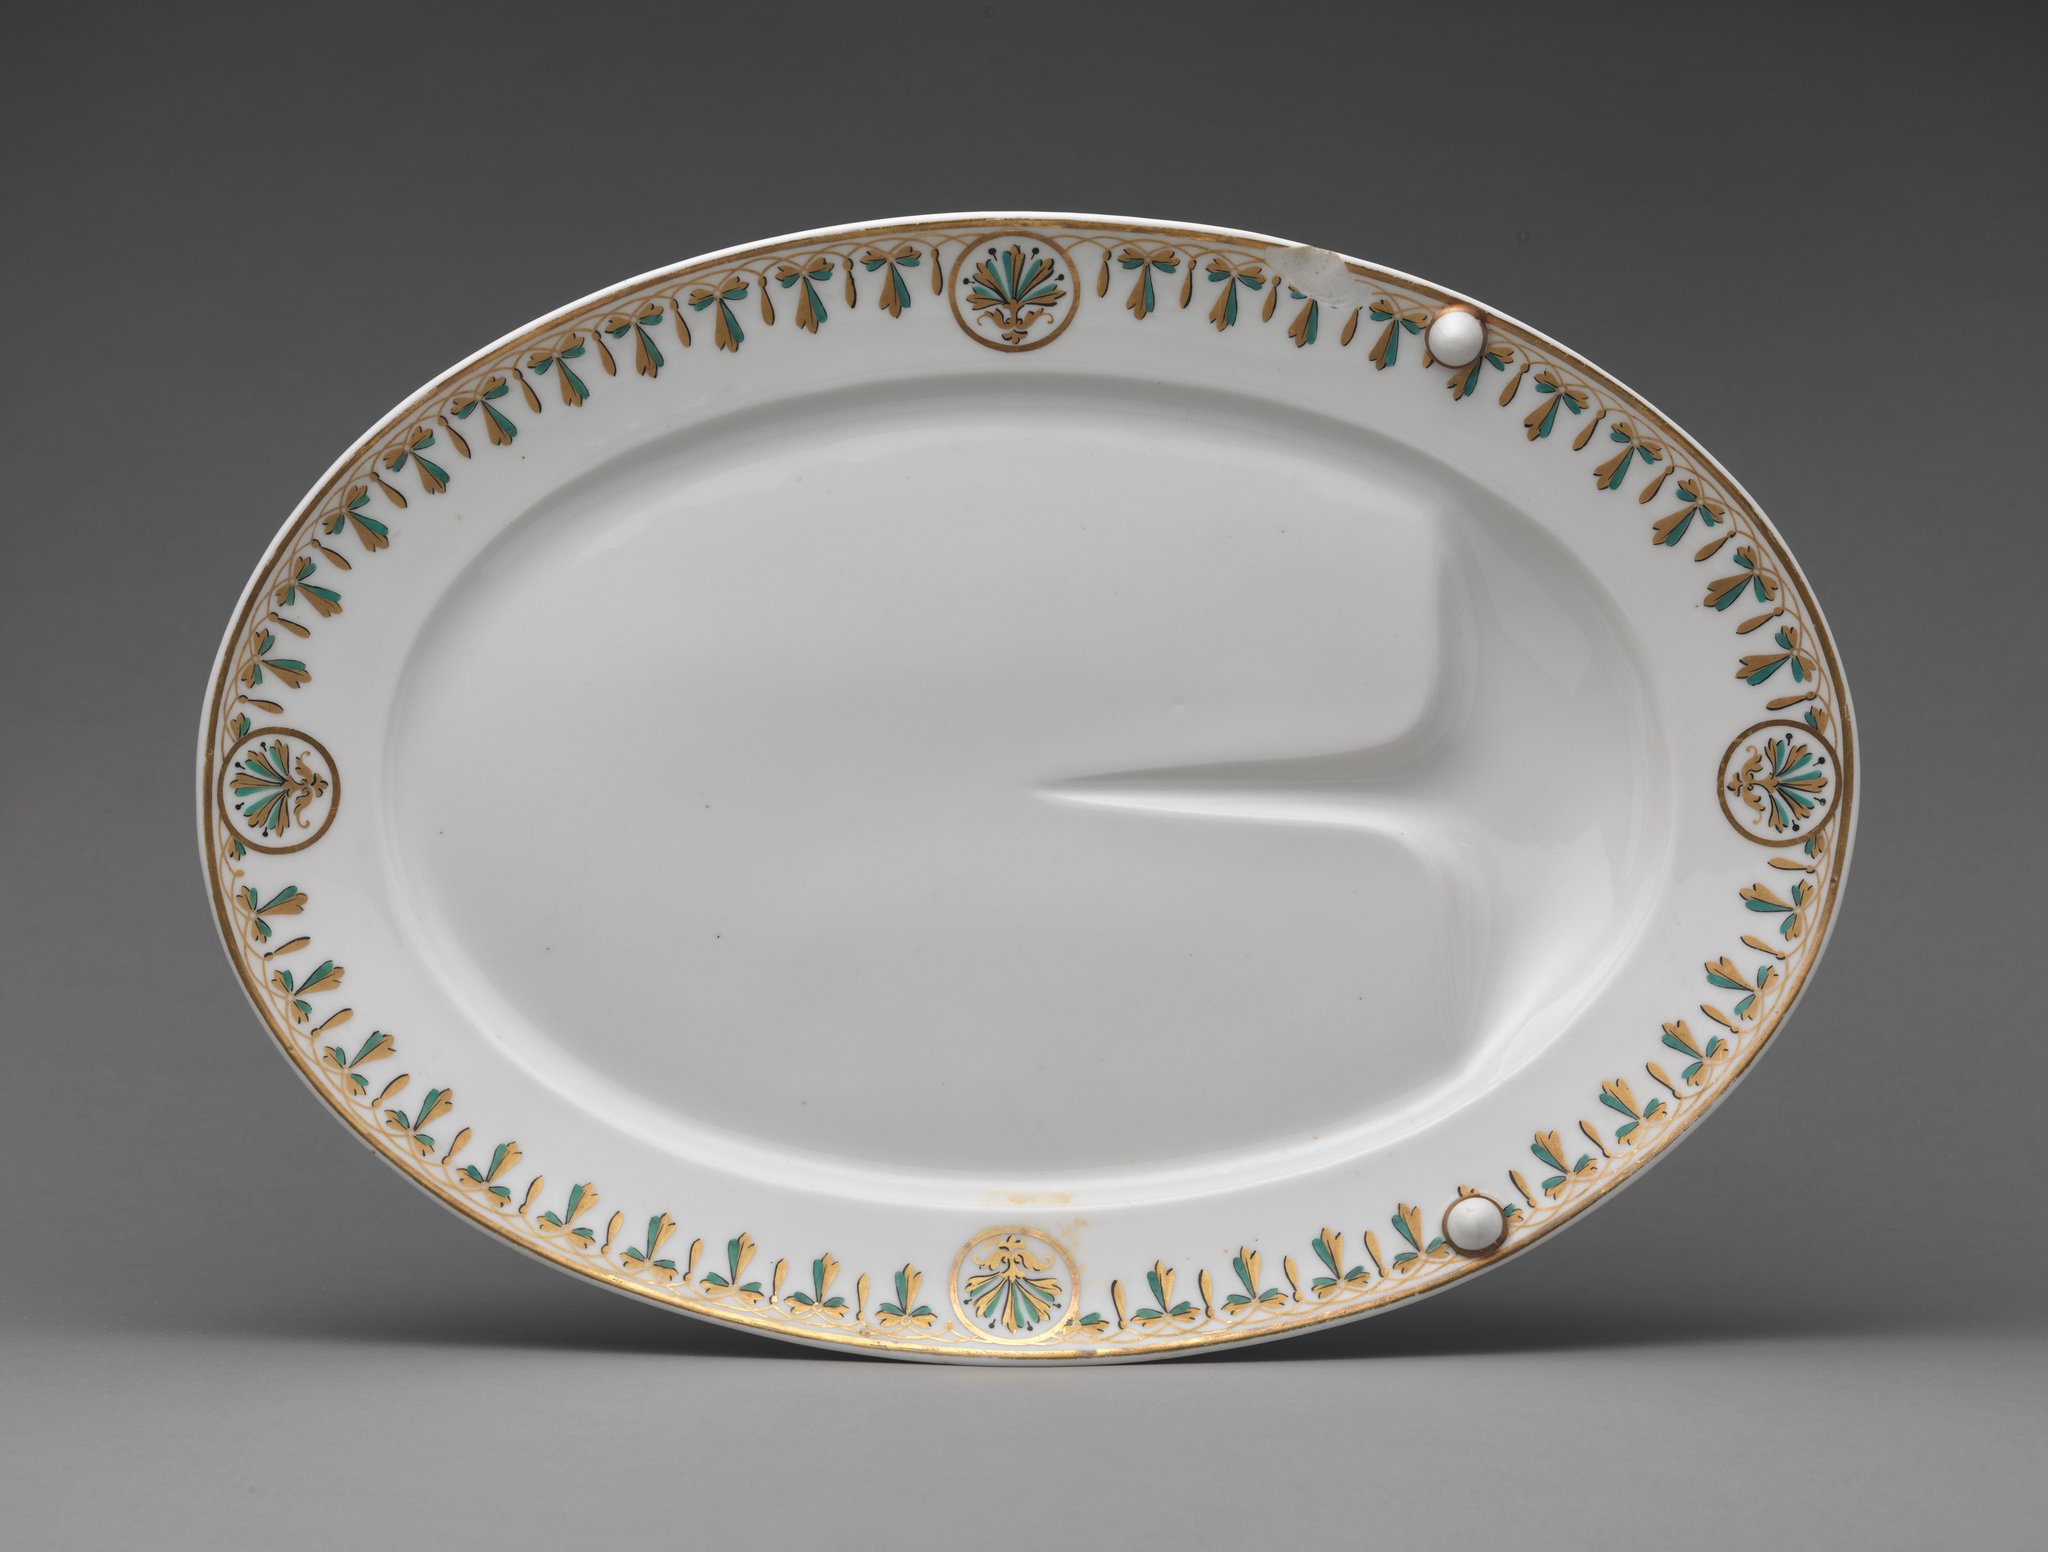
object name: roast platter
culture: american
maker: union porcelain works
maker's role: maker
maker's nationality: american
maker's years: 1863-1922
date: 1885-1886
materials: porcelain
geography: united states